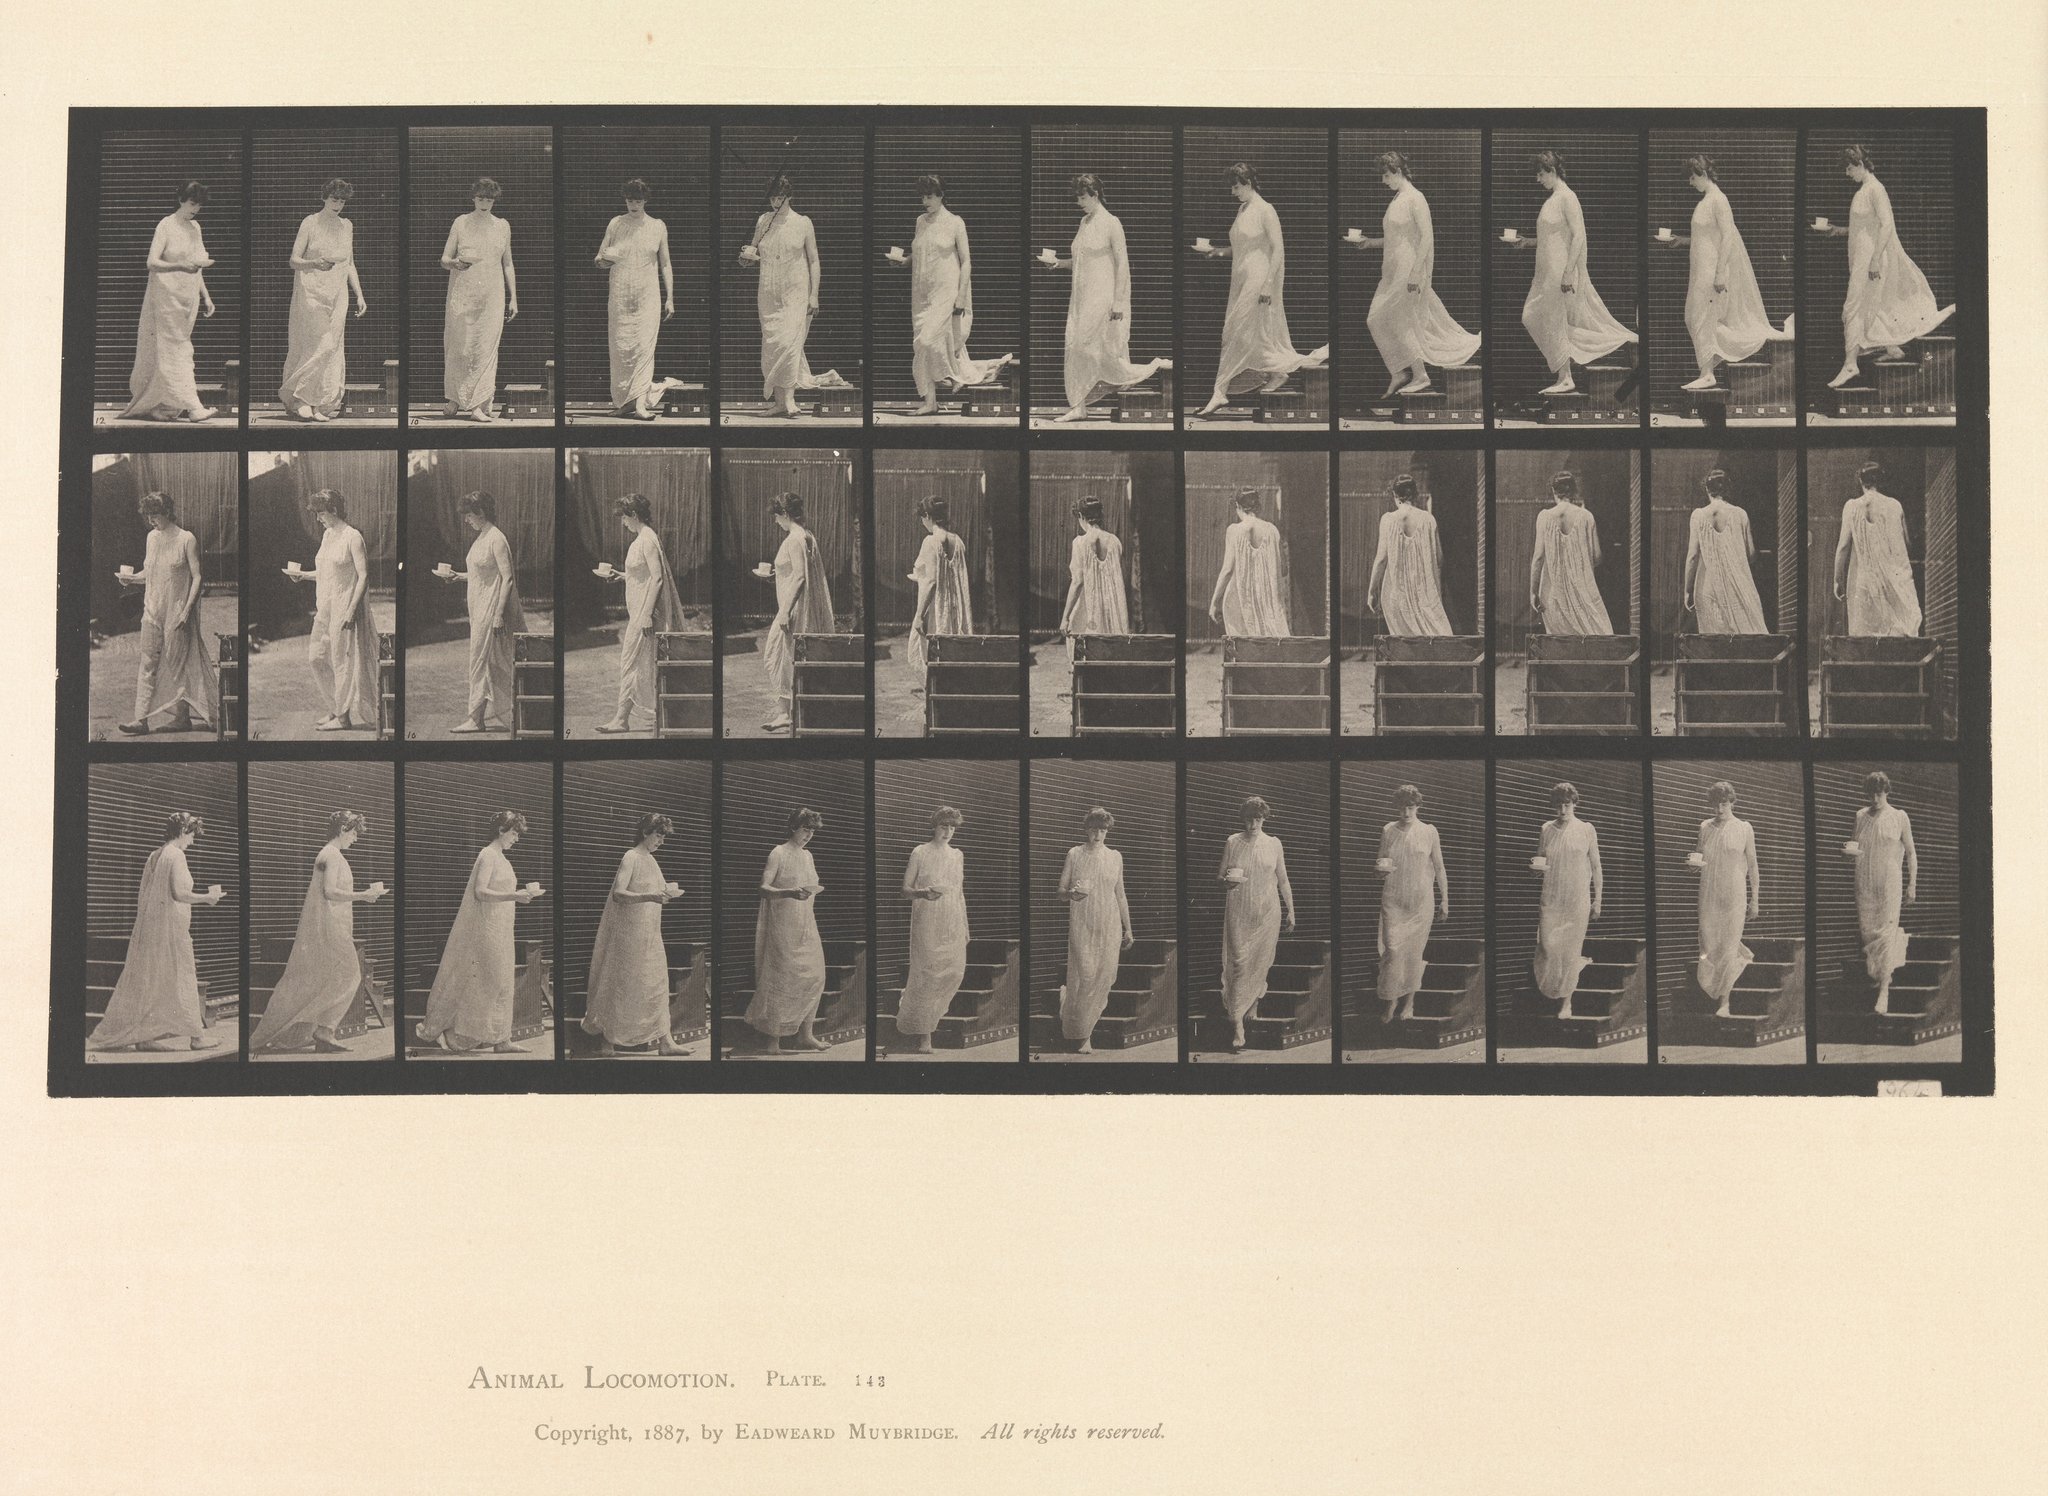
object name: photographically illustrated book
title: Animal Locomotion. An Electro-Photographic Investigation... of Animal Movements. Commenced 1872 - Completed 1885. Volume VI, Woman (Semi-Nude and Transparent Drapery) Children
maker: eadweard muybridge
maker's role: artist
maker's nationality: british and american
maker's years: 1830-1904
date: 1880-1889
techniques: photogravure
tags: women